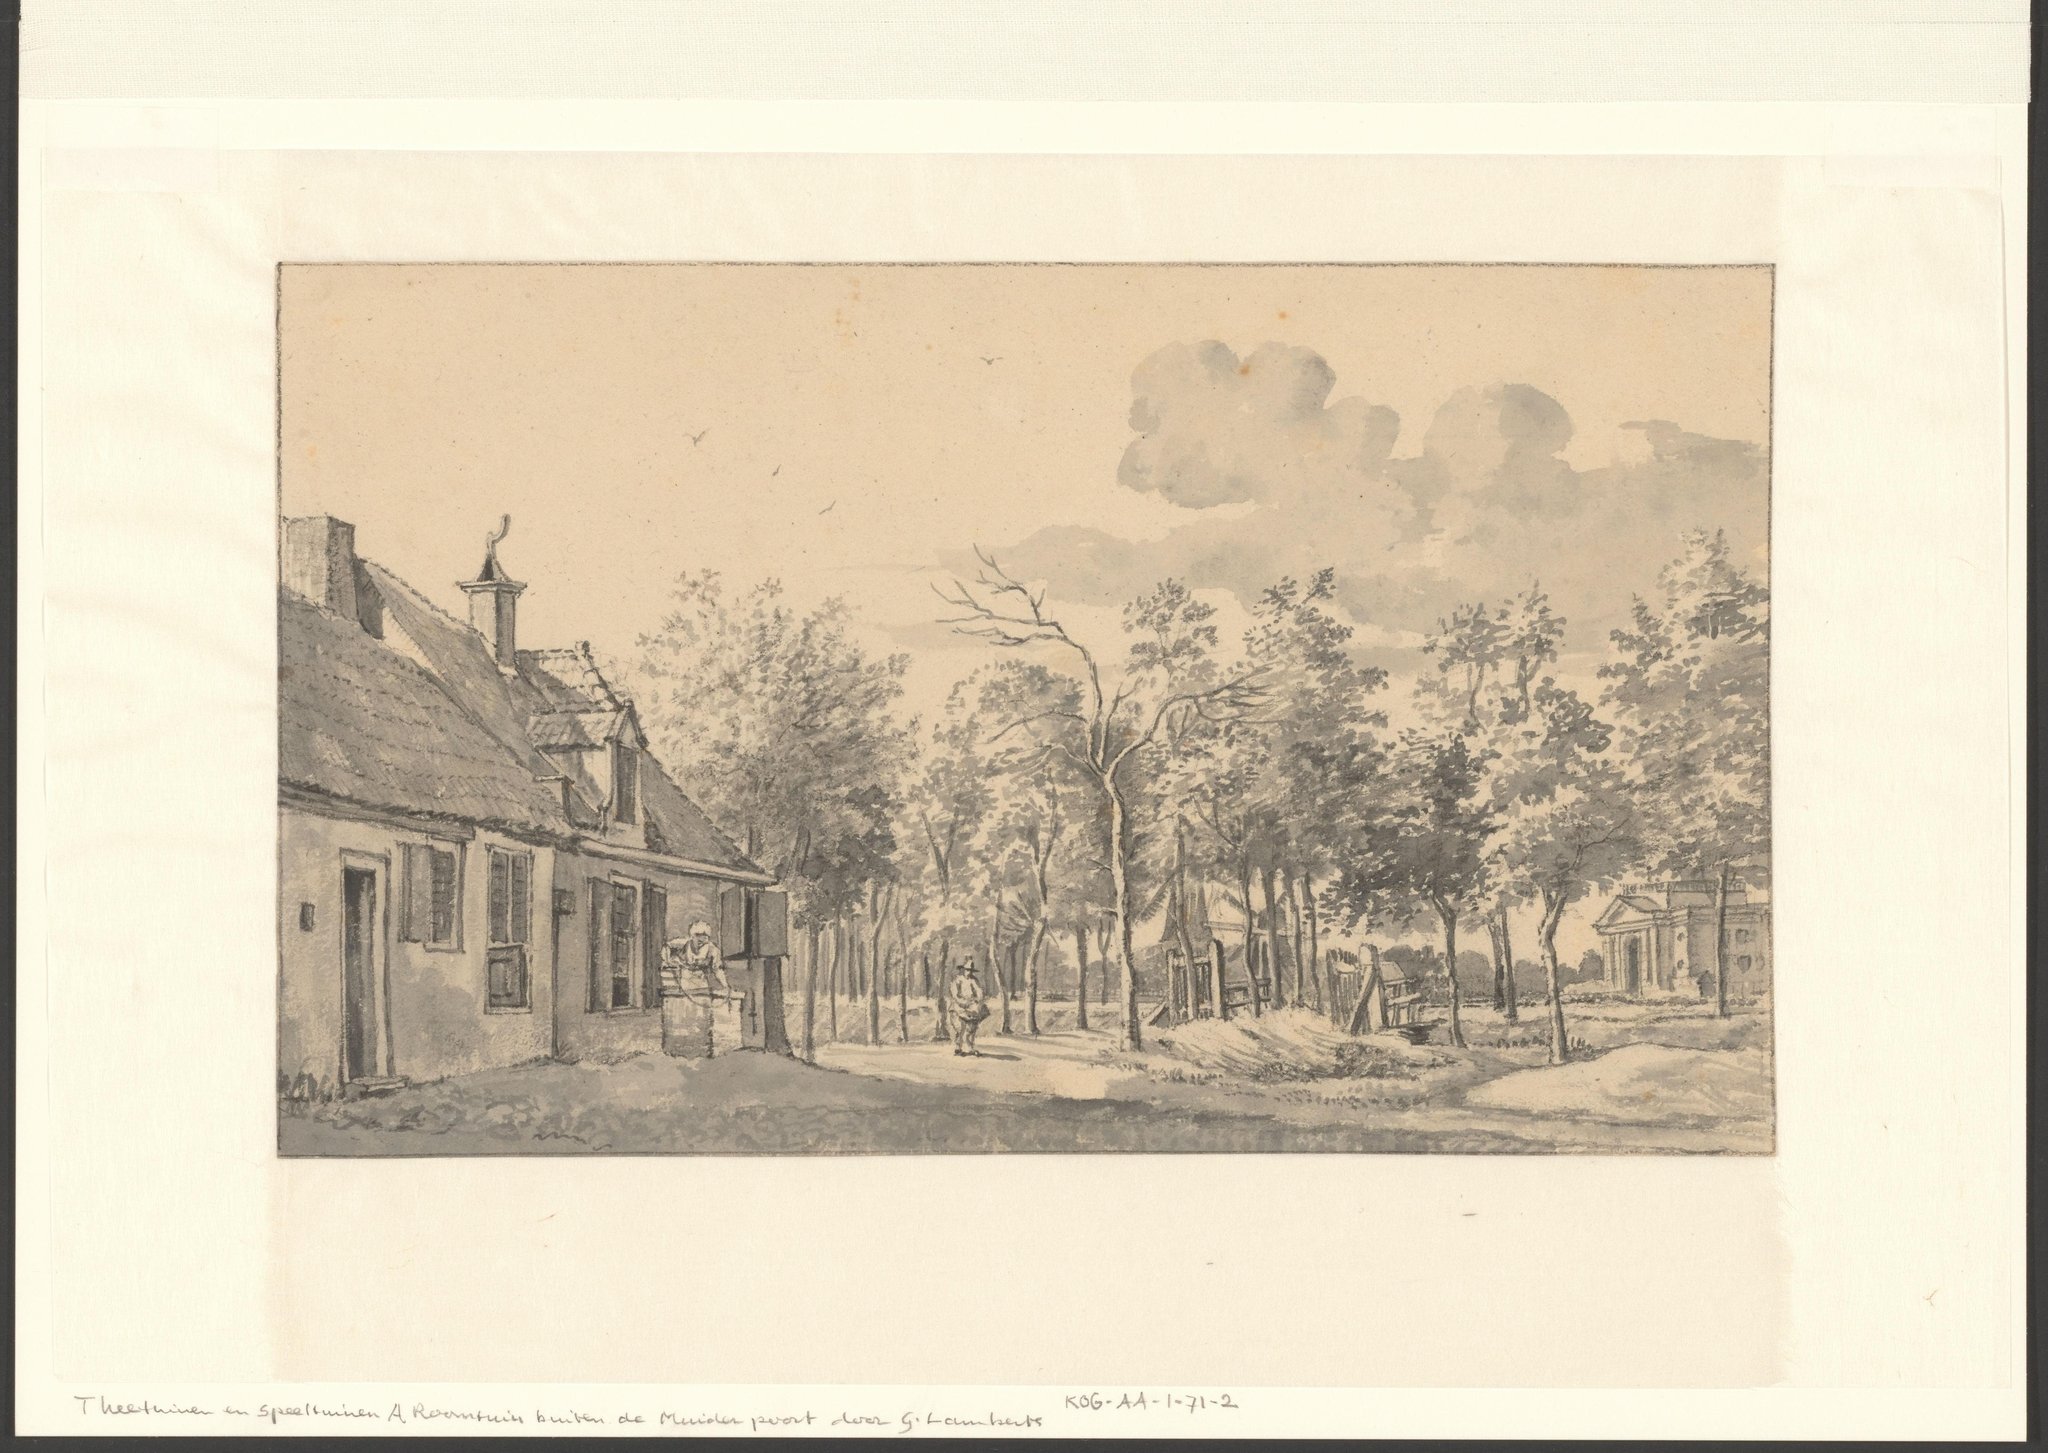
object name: drawing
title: Gezicht op de Roomtuintjes en de Muiderpoort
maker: gerrit lamberts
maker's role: bookseller, draughtsman, print maker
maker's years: 1776-1850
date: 1817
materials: chalk, ink, paper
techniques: brush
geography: amsterdam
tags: city-view in general; 'veduta', canal, inn, coffee-house, public house, etc., tea garden, garden restaurant, city-gate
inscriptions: inscription: ‘71-II / A theetuinen en / speeltuinen / XXXIII / Kon. Oudh. kundig Genootschap / vE’, signature, date and inscription: ‘Gezigt van de (...) G. Lamberts. 1817.’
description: Onderwerpsrubriek binnen de Atlas Amsterdam: Theetuinen en Speeltuinen.